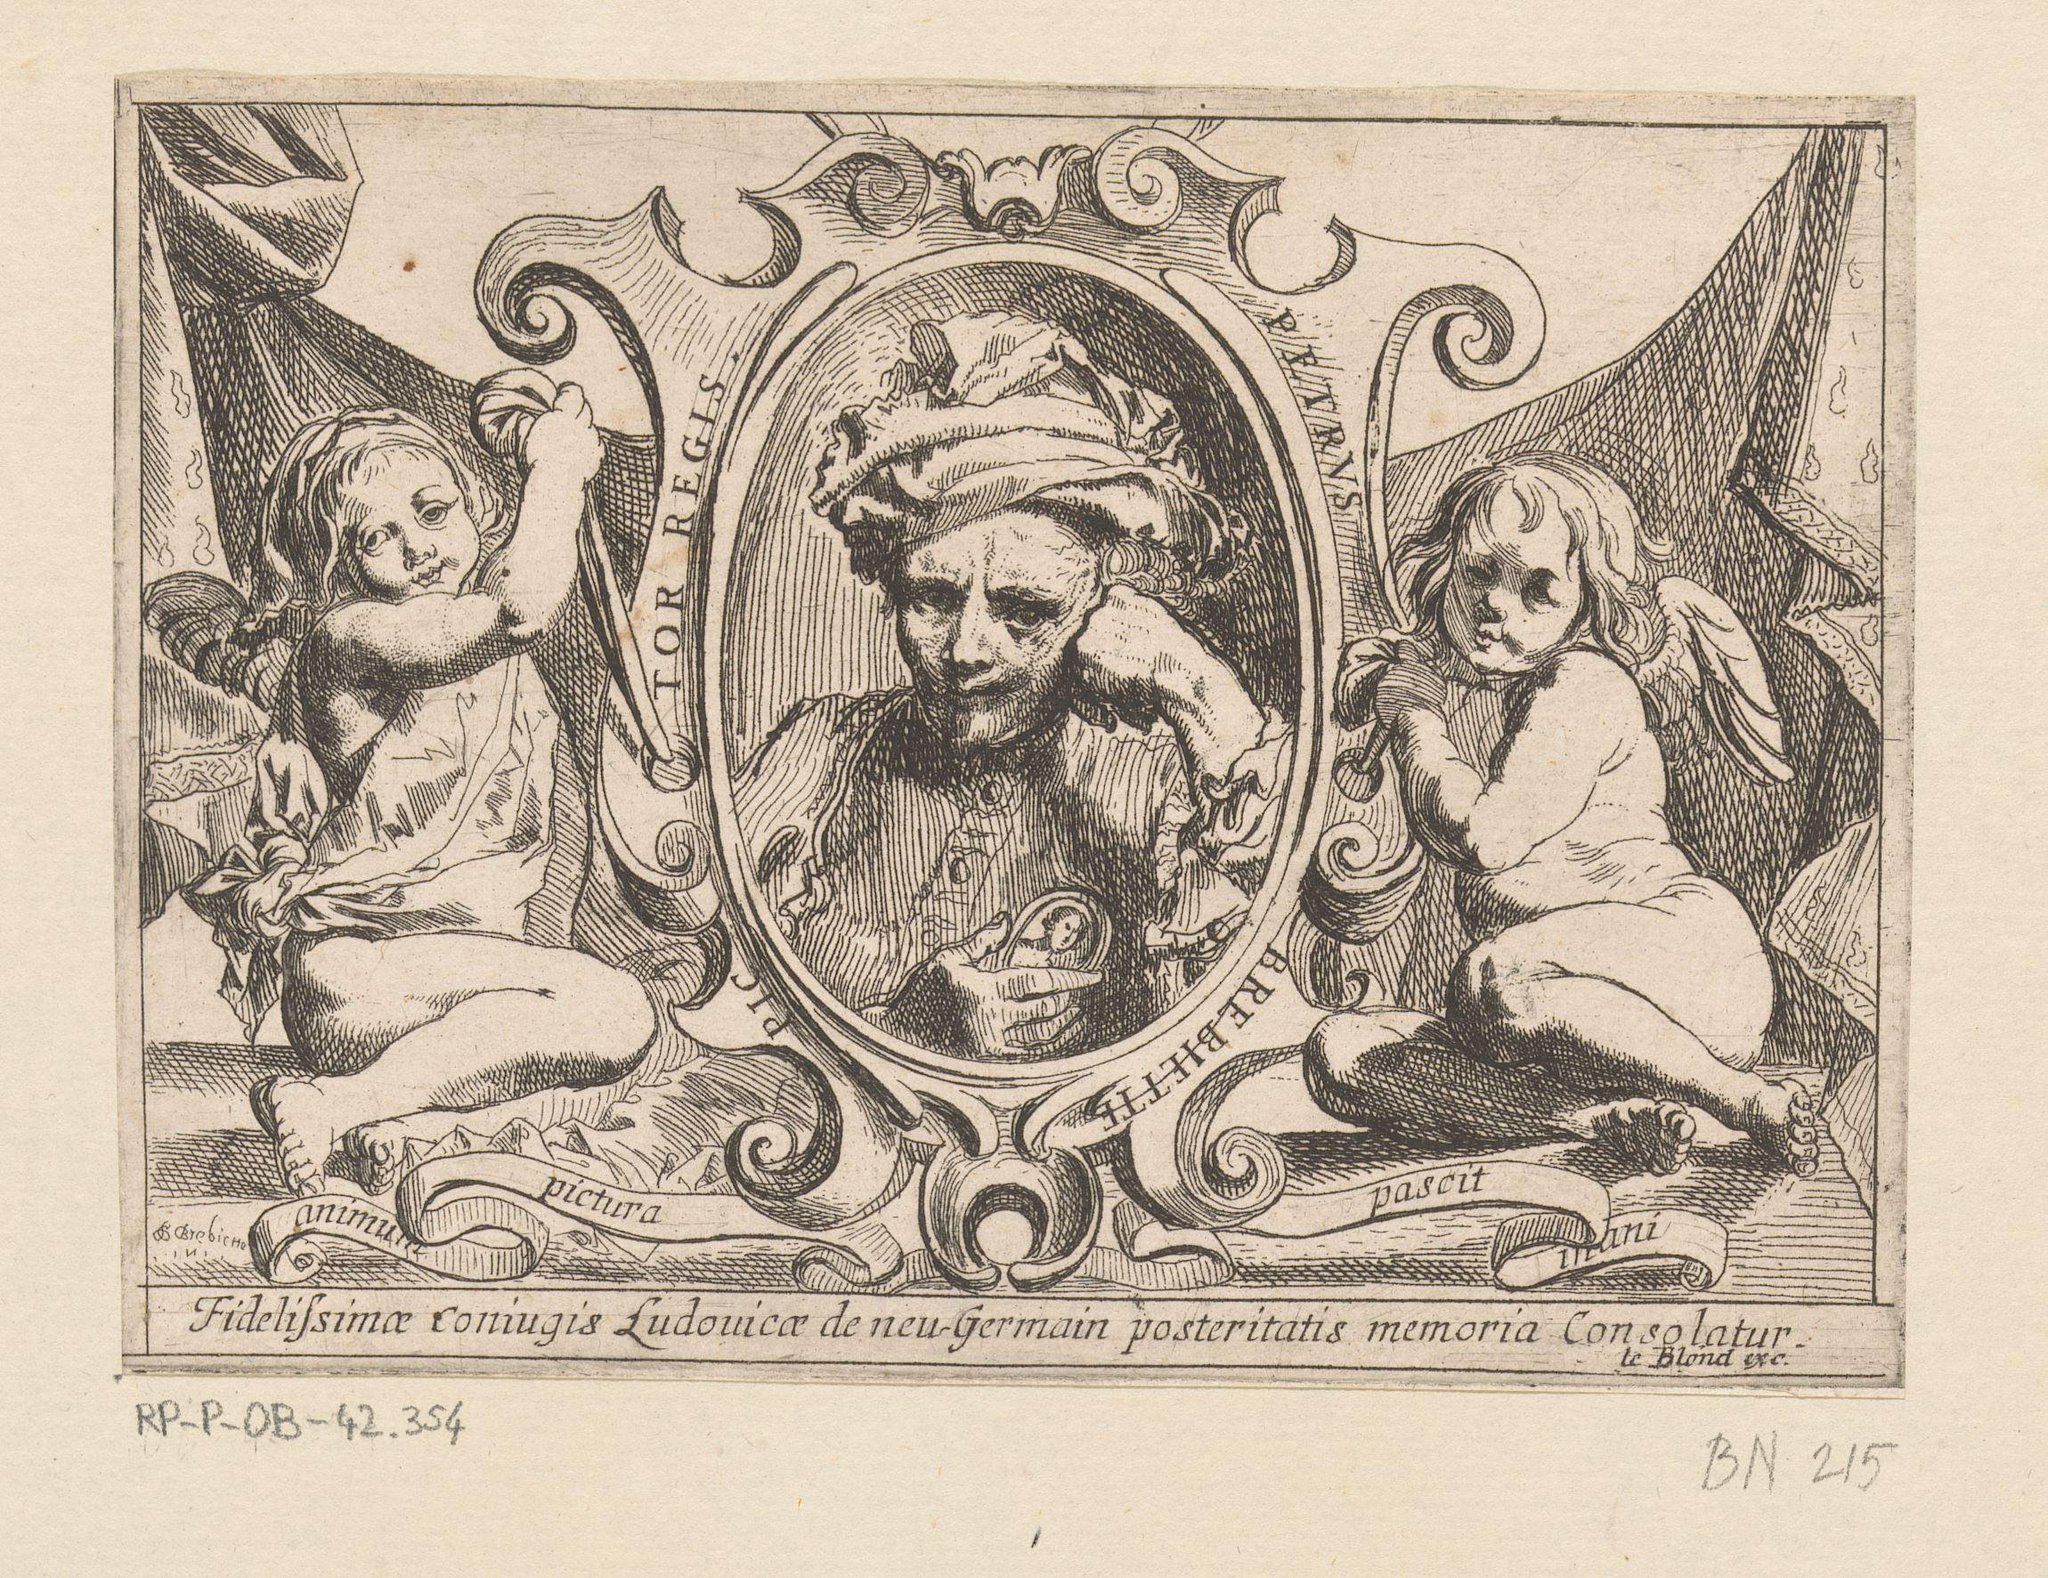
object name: print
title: Zelfportret van Pierre Brebiette in een lijst opgehouden door putti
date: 1608-1650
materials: paper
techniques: etching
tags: pierre brebiette, historical persons, ornament ~ cartouche, portrait, self-portrait of artist, cupids: 'amores', 'amoretti', 'putti'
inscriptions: collector's mark: Lugt 240